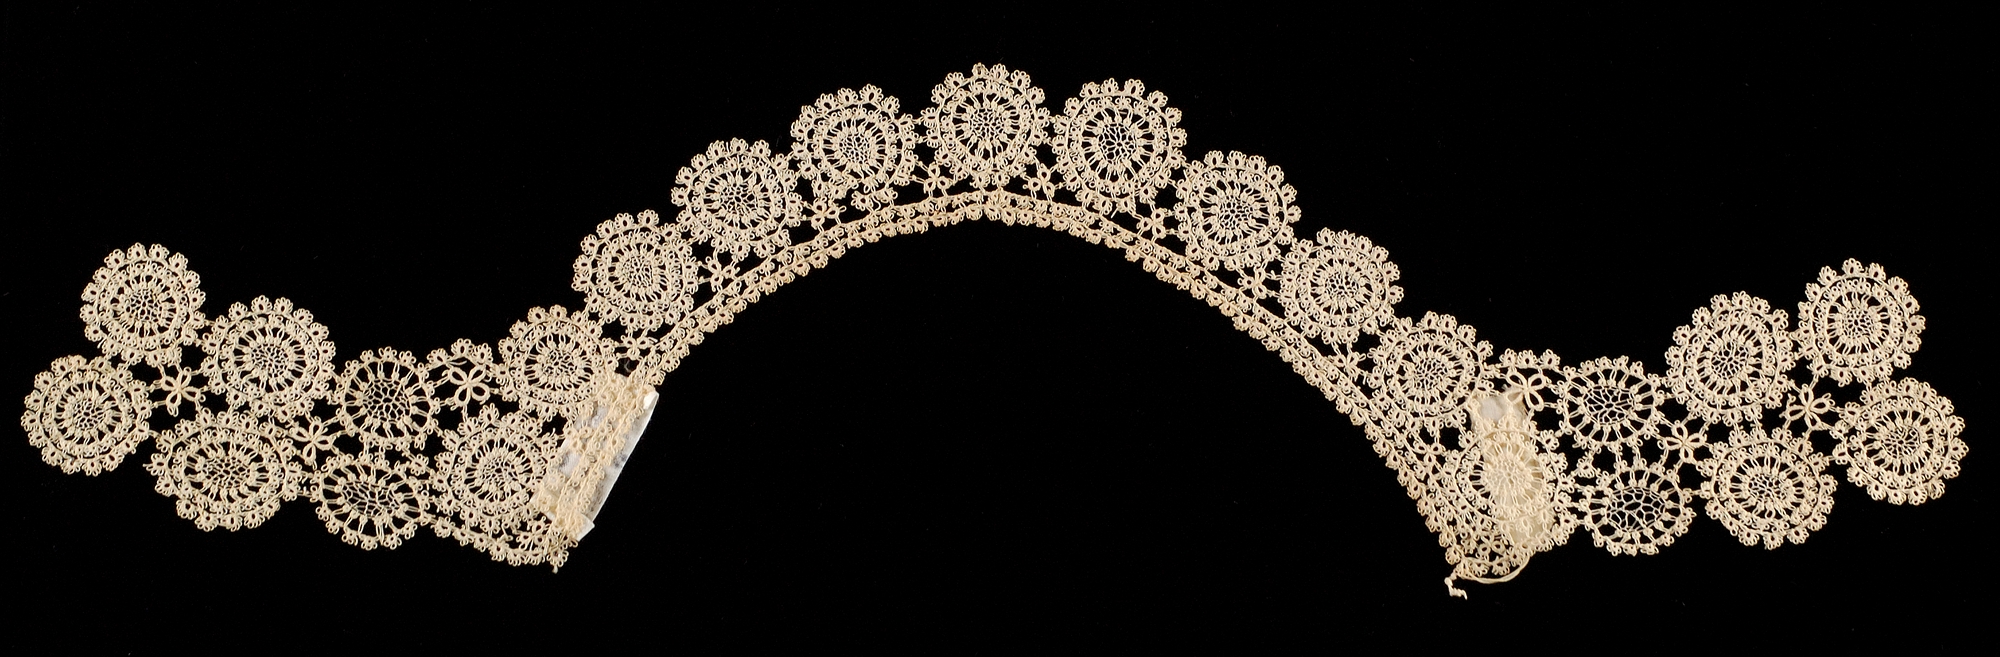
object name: collar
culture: american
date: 1840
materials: linen